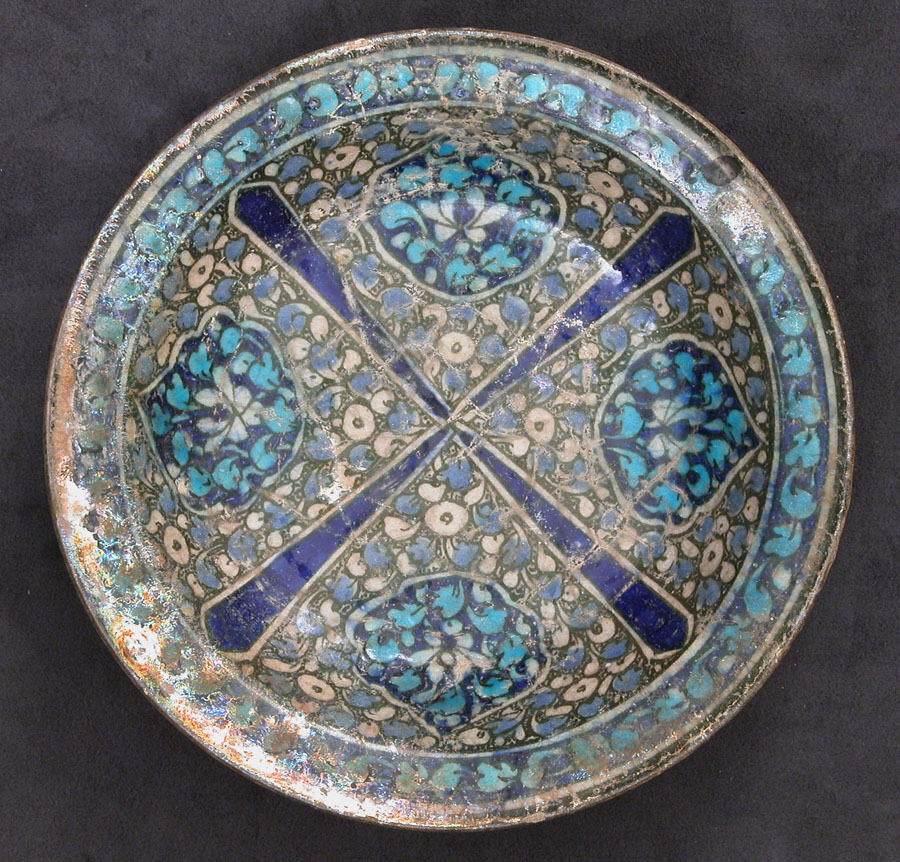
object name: dish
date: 1301-1400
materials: stonepaste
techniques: painting, underglaze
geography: iran